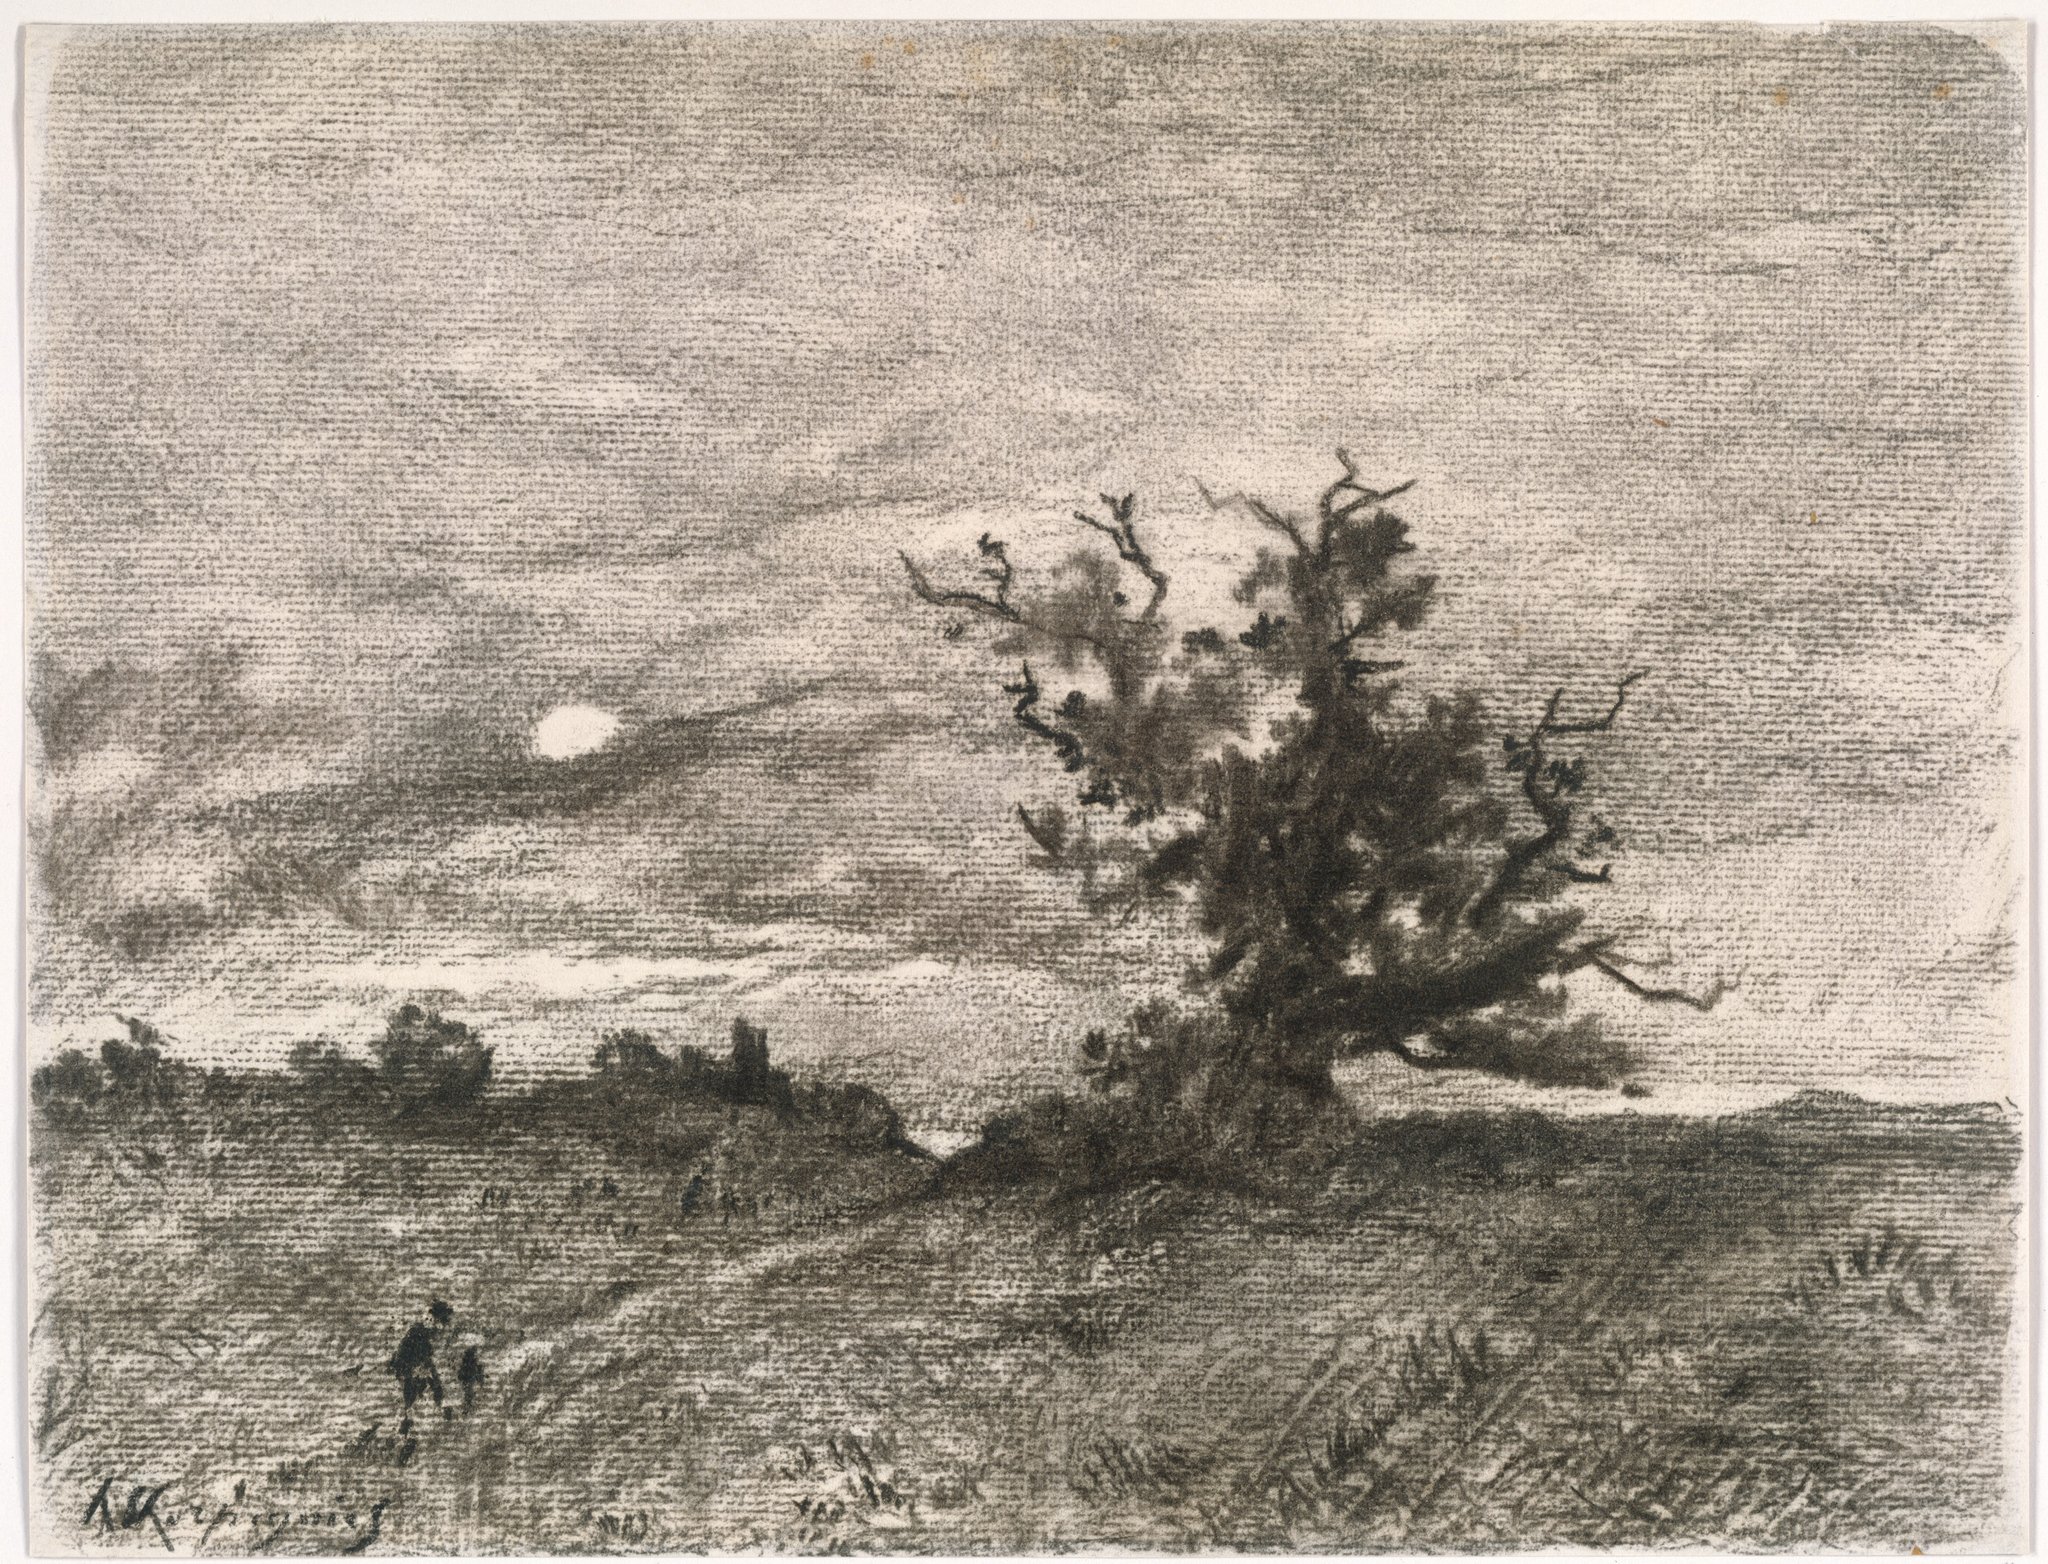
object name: drawing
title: Moonlit Landscape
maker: henri-joseph harpignies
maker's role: artist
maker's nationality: french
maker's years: 1819-1916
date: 1900-1910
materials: charcoal, paper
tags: moon,landscapes,trees